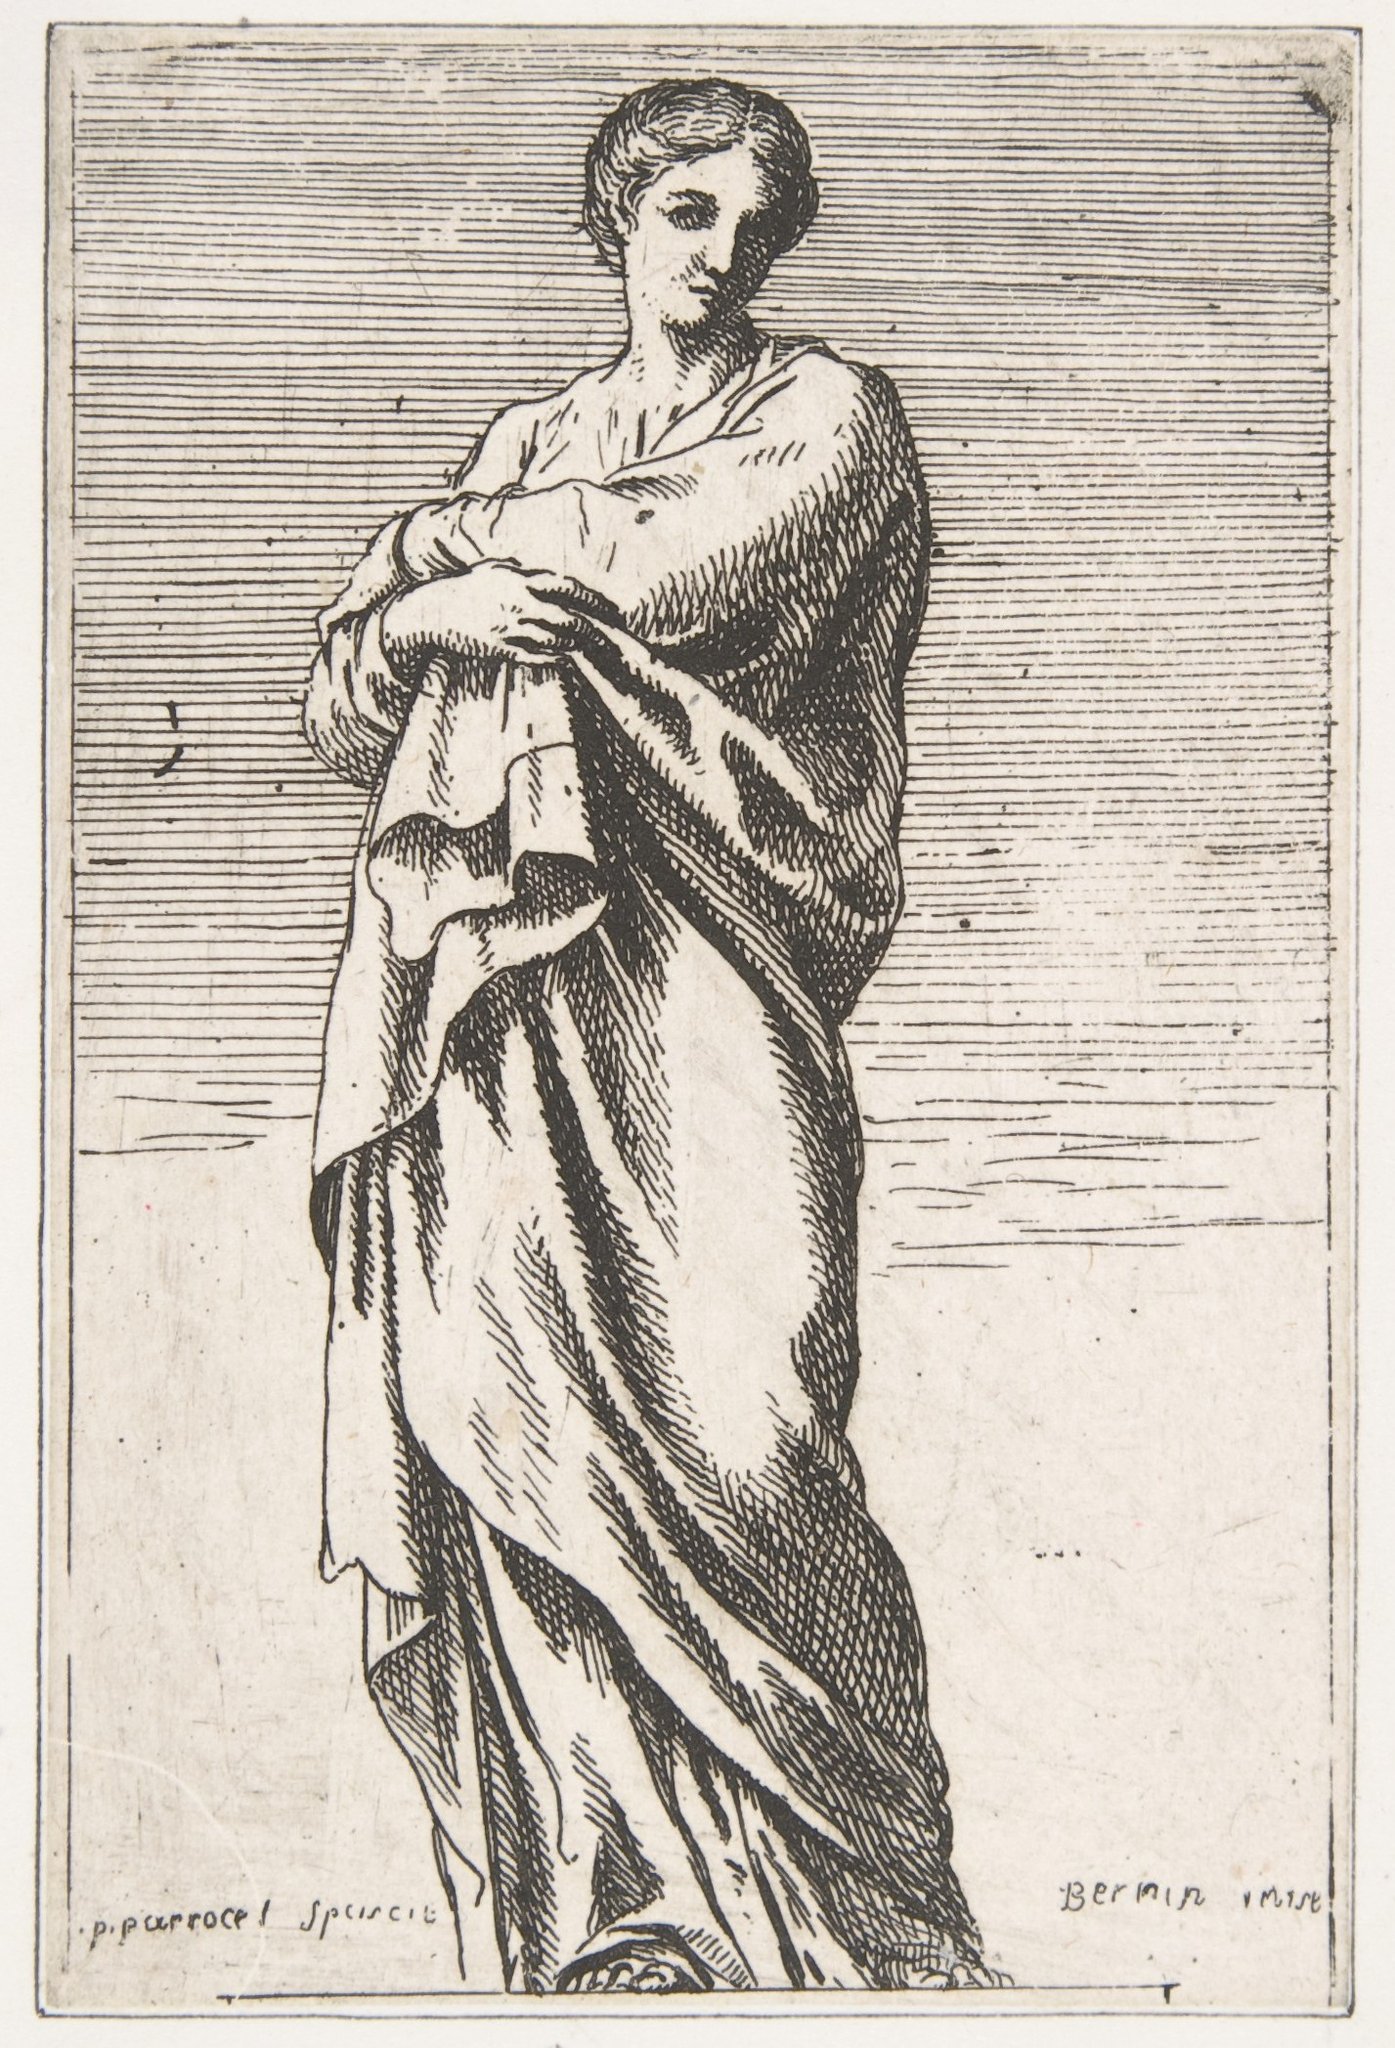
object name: print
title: Standing Female Figure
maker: pierre ignace parrocel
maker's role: artist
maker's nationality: french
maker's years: 1702-1775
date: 1739-1740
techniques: etching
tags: women